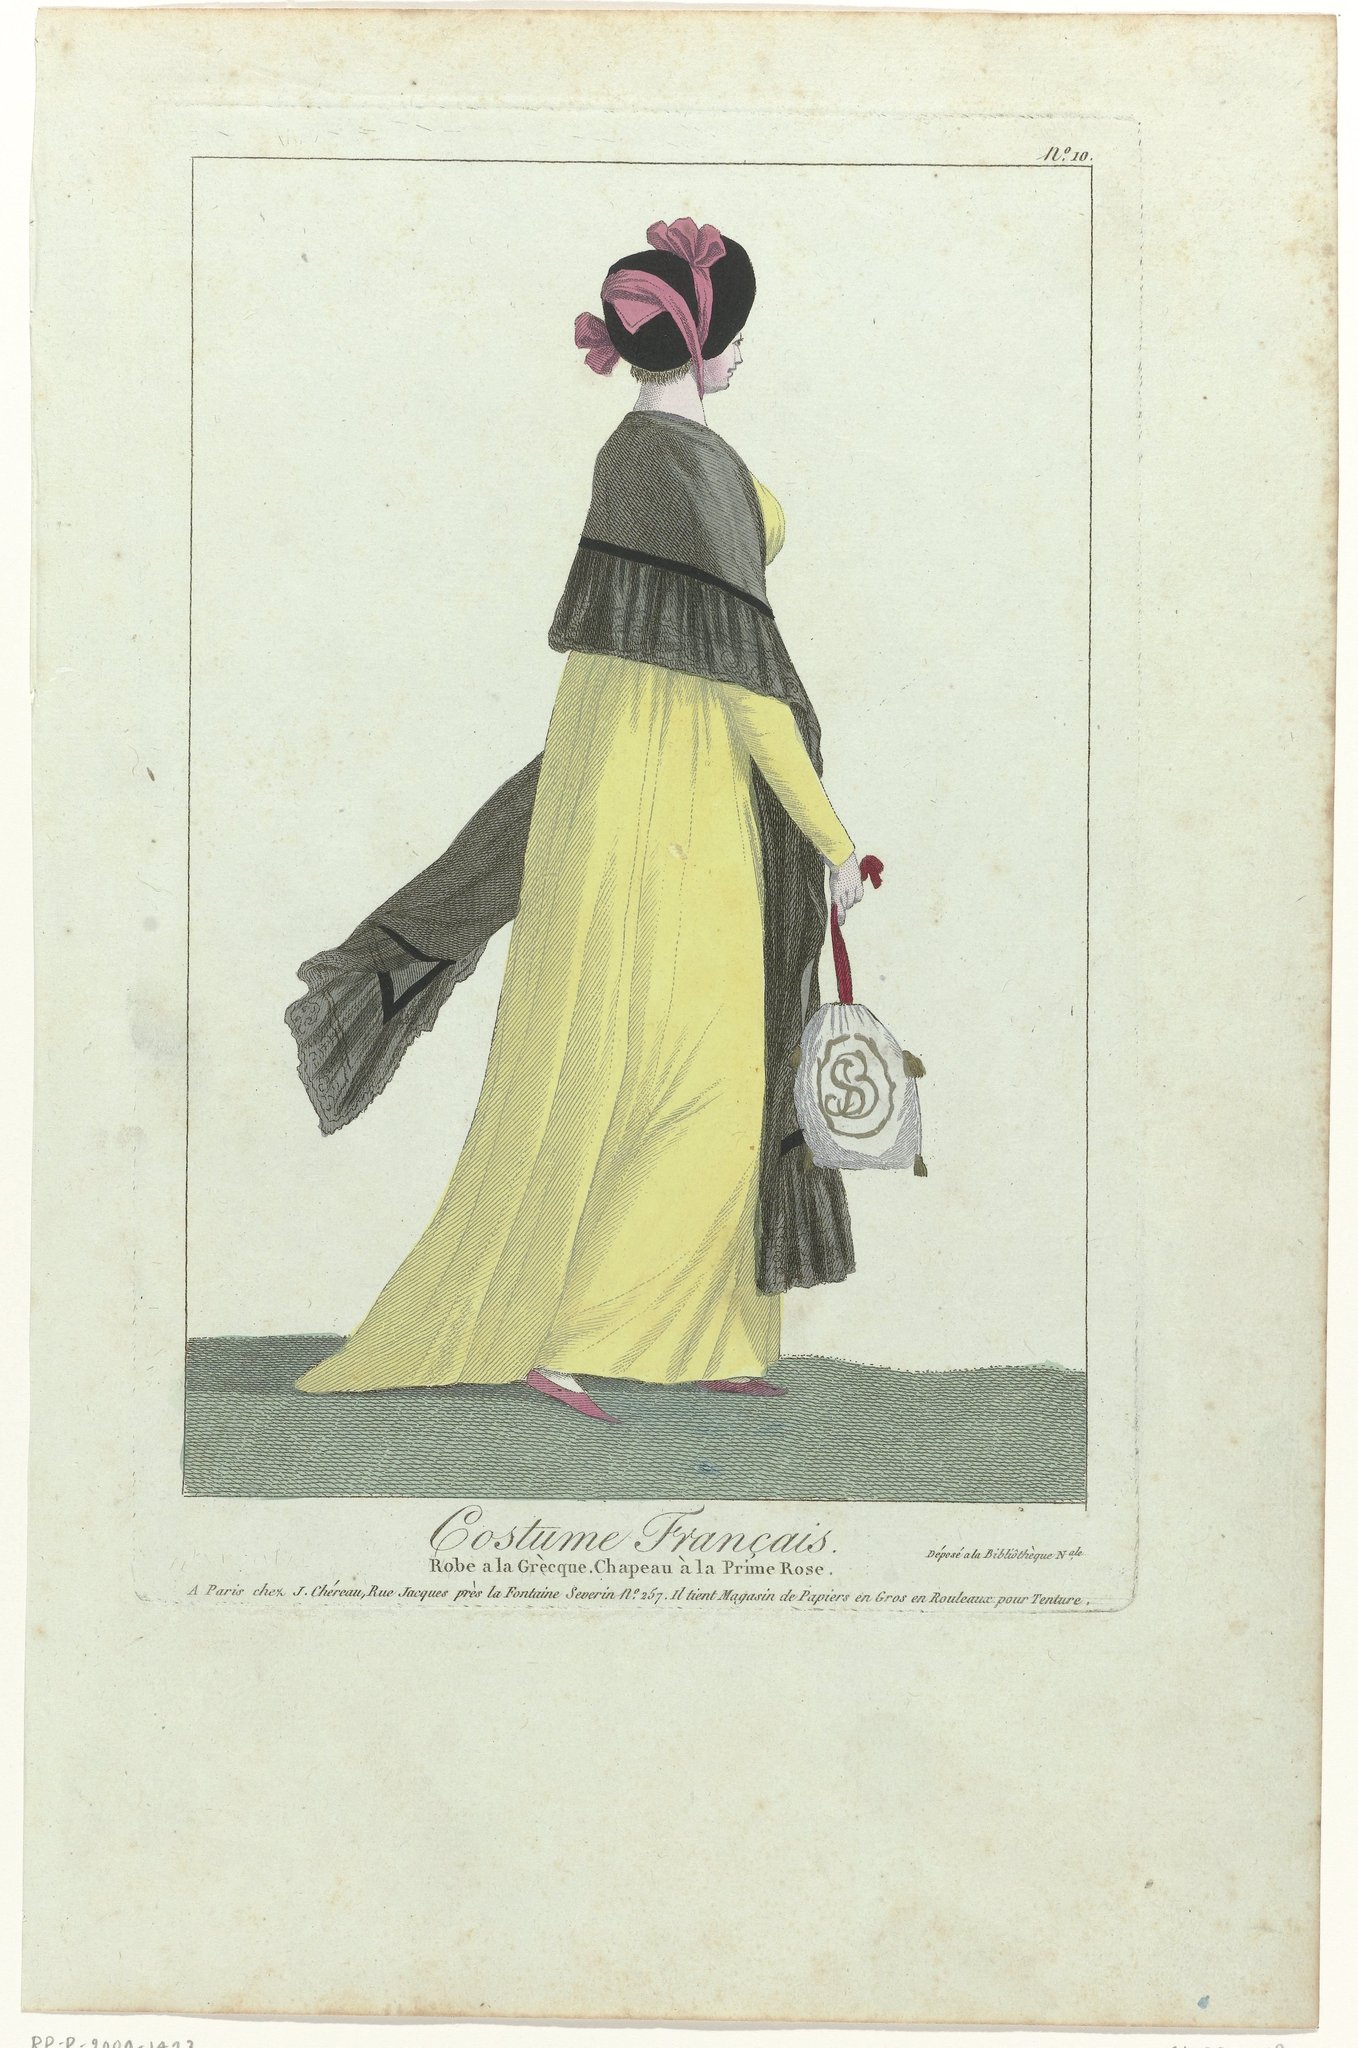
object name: fashion print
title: Costume Français, No.10 : Robe à la Grecque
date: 1799-1810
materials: paper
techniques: engraving, etching, hand coloring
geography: paris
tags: clothing for the upper part of the body (shawl) (+ women's clothes), bag (handbag) (+ women's clothes), fashion plates, head-gear: hat (+ women's clothes), dress, gown (+ women's clothes)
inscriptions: caption: ‘Robe à la Grecque. Chapeau à la Prime Rose.’, caption: ‘Déposé à la Bibliothèque N.ale’, title: ‘Costume Français’, address: ‘A Paris, chez J. Chéreau. Rue Jacques près la Fontaine Severin, No. 257. Il tient Magasin de Papiers en Gros en Rouleaux pour Tenture.’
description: Vrouw, op de rug gezien, in een 'robe à la Grecque'. Op het hoofd een hoed: 'chapeau à la Prime Rose'. Verdere accessoires: lange sjaal om de schouders, buidel met sierletters, platte schoenen met puntige neuzen. De prent maakt deel uit van een serie van 142 modeprenten, waarvan er 115 zijn geïdentificeerd, uitgegeven door J. Chéreau, Parijs, 1799-1810.